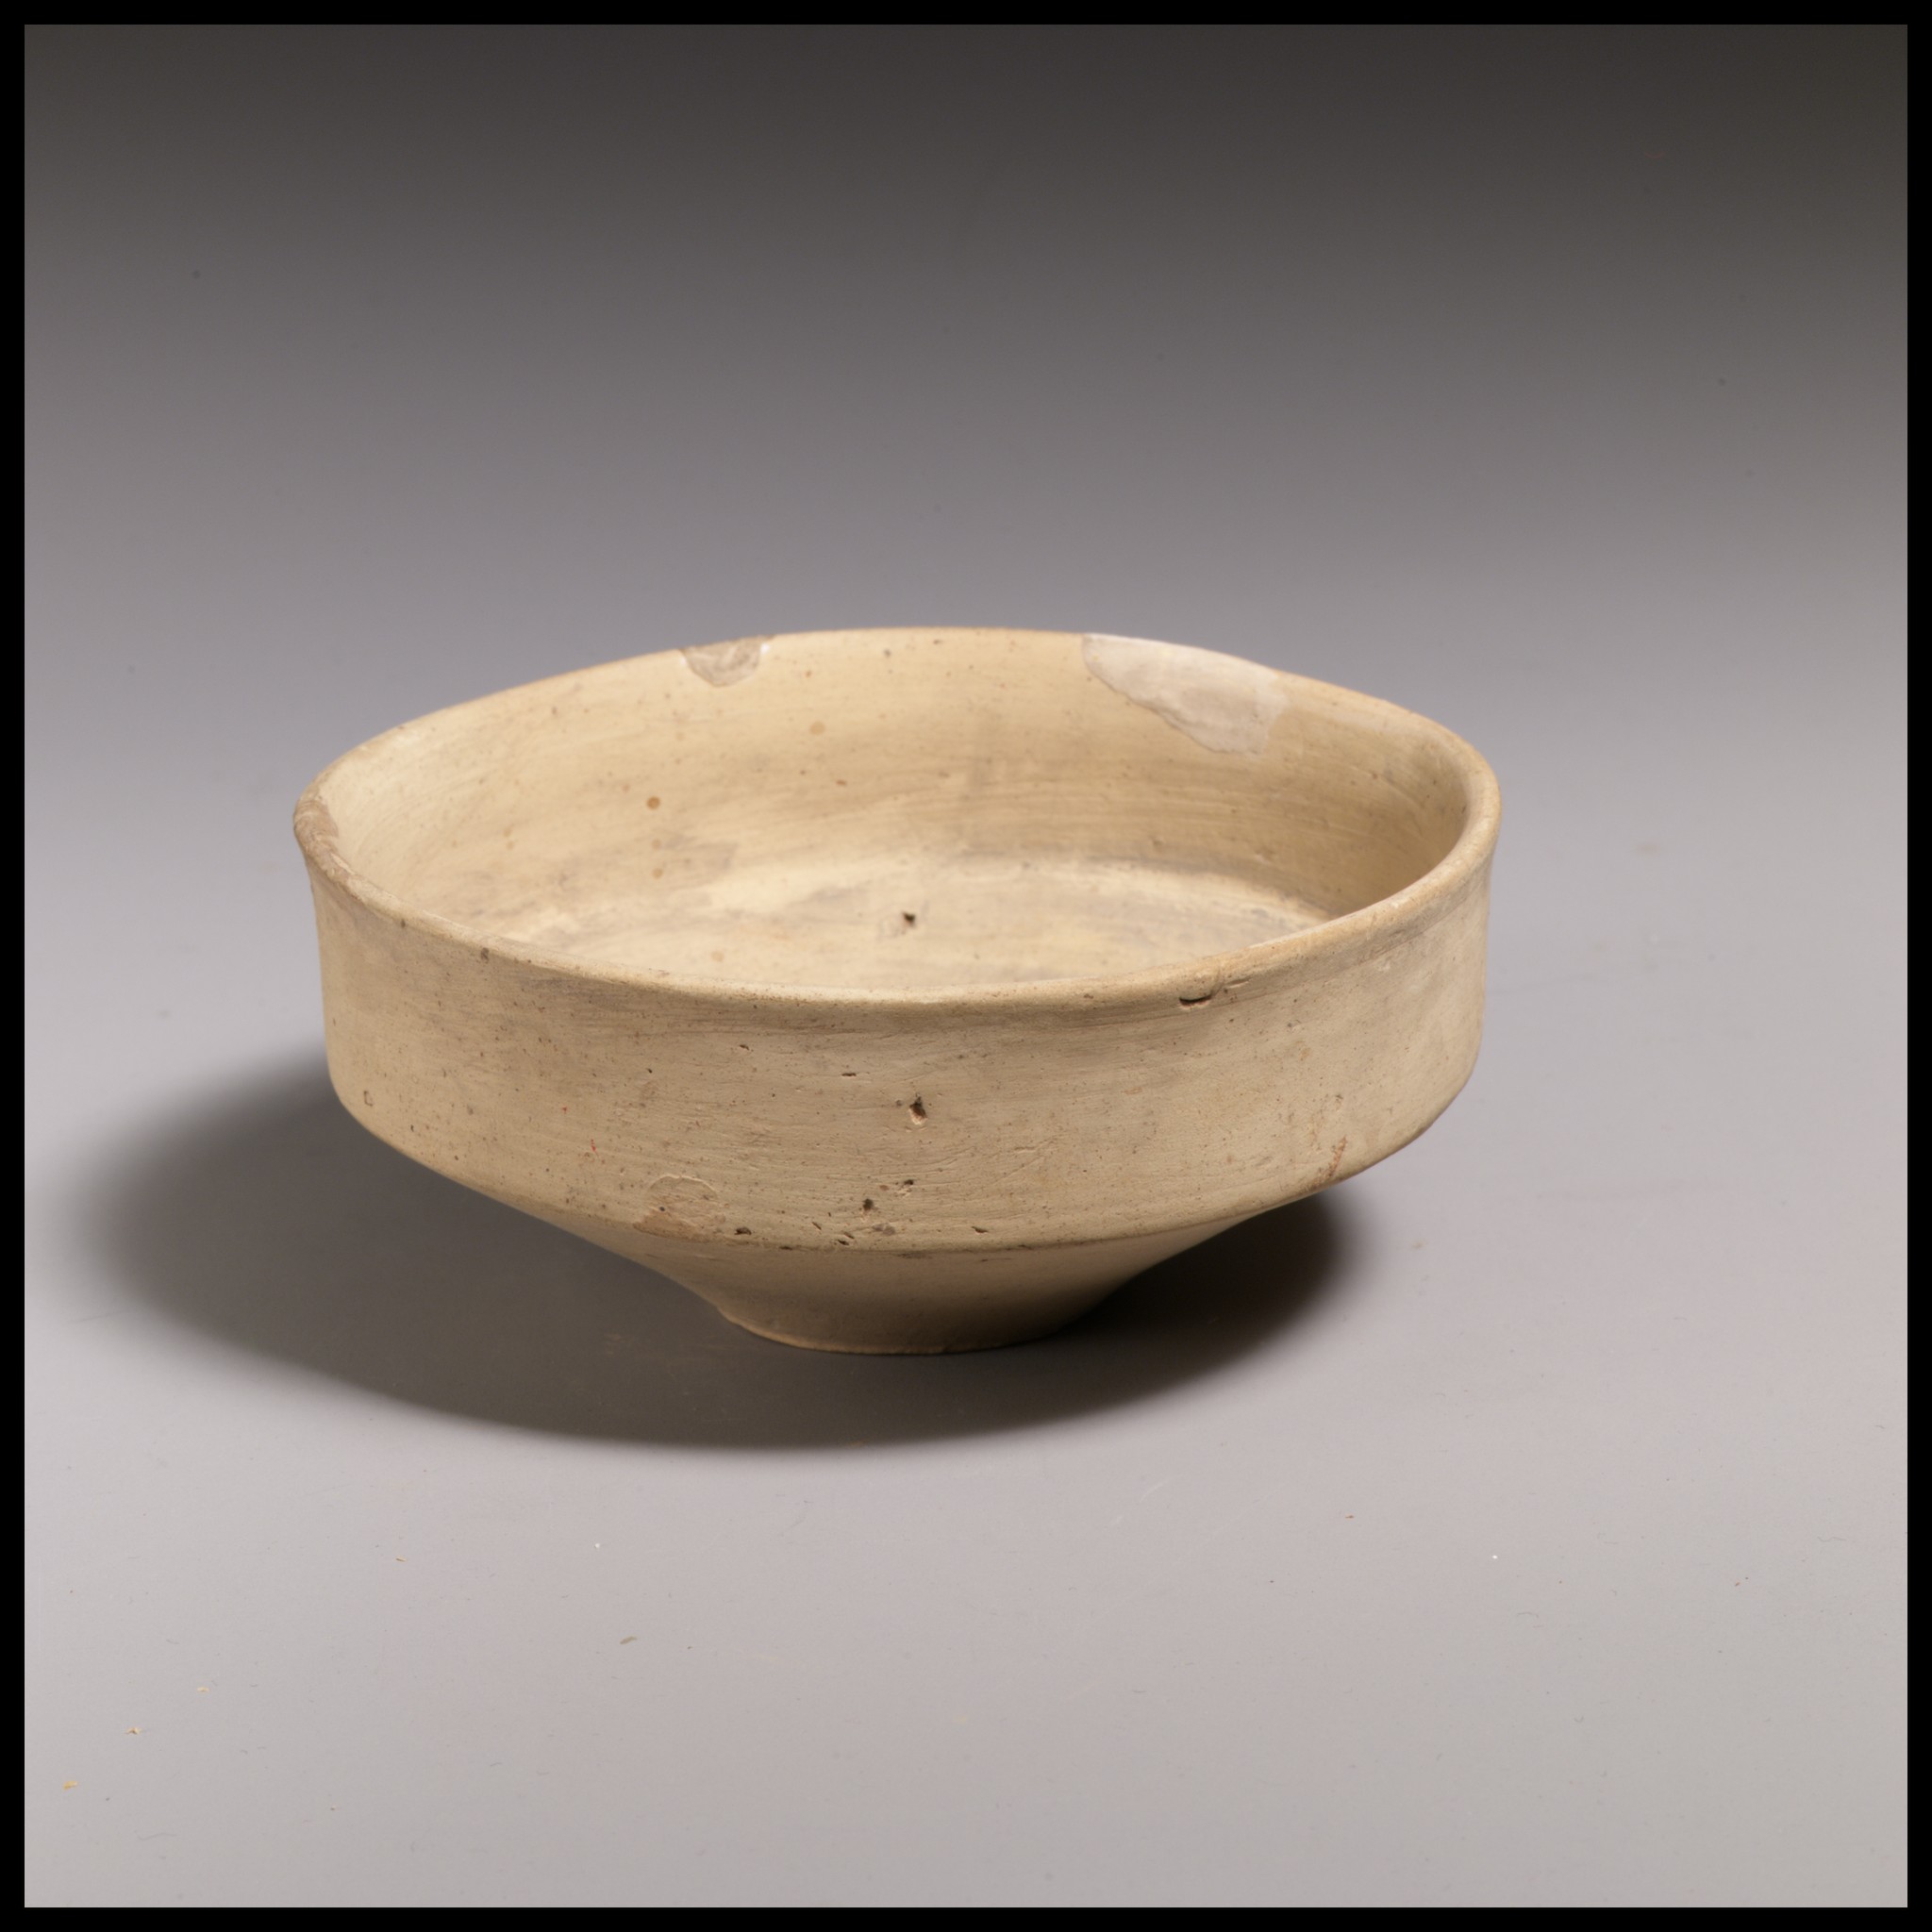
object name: bowl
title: Terracotta shallow angular bowl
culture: mycenaean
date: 1300-1090 BCE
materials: terracotta